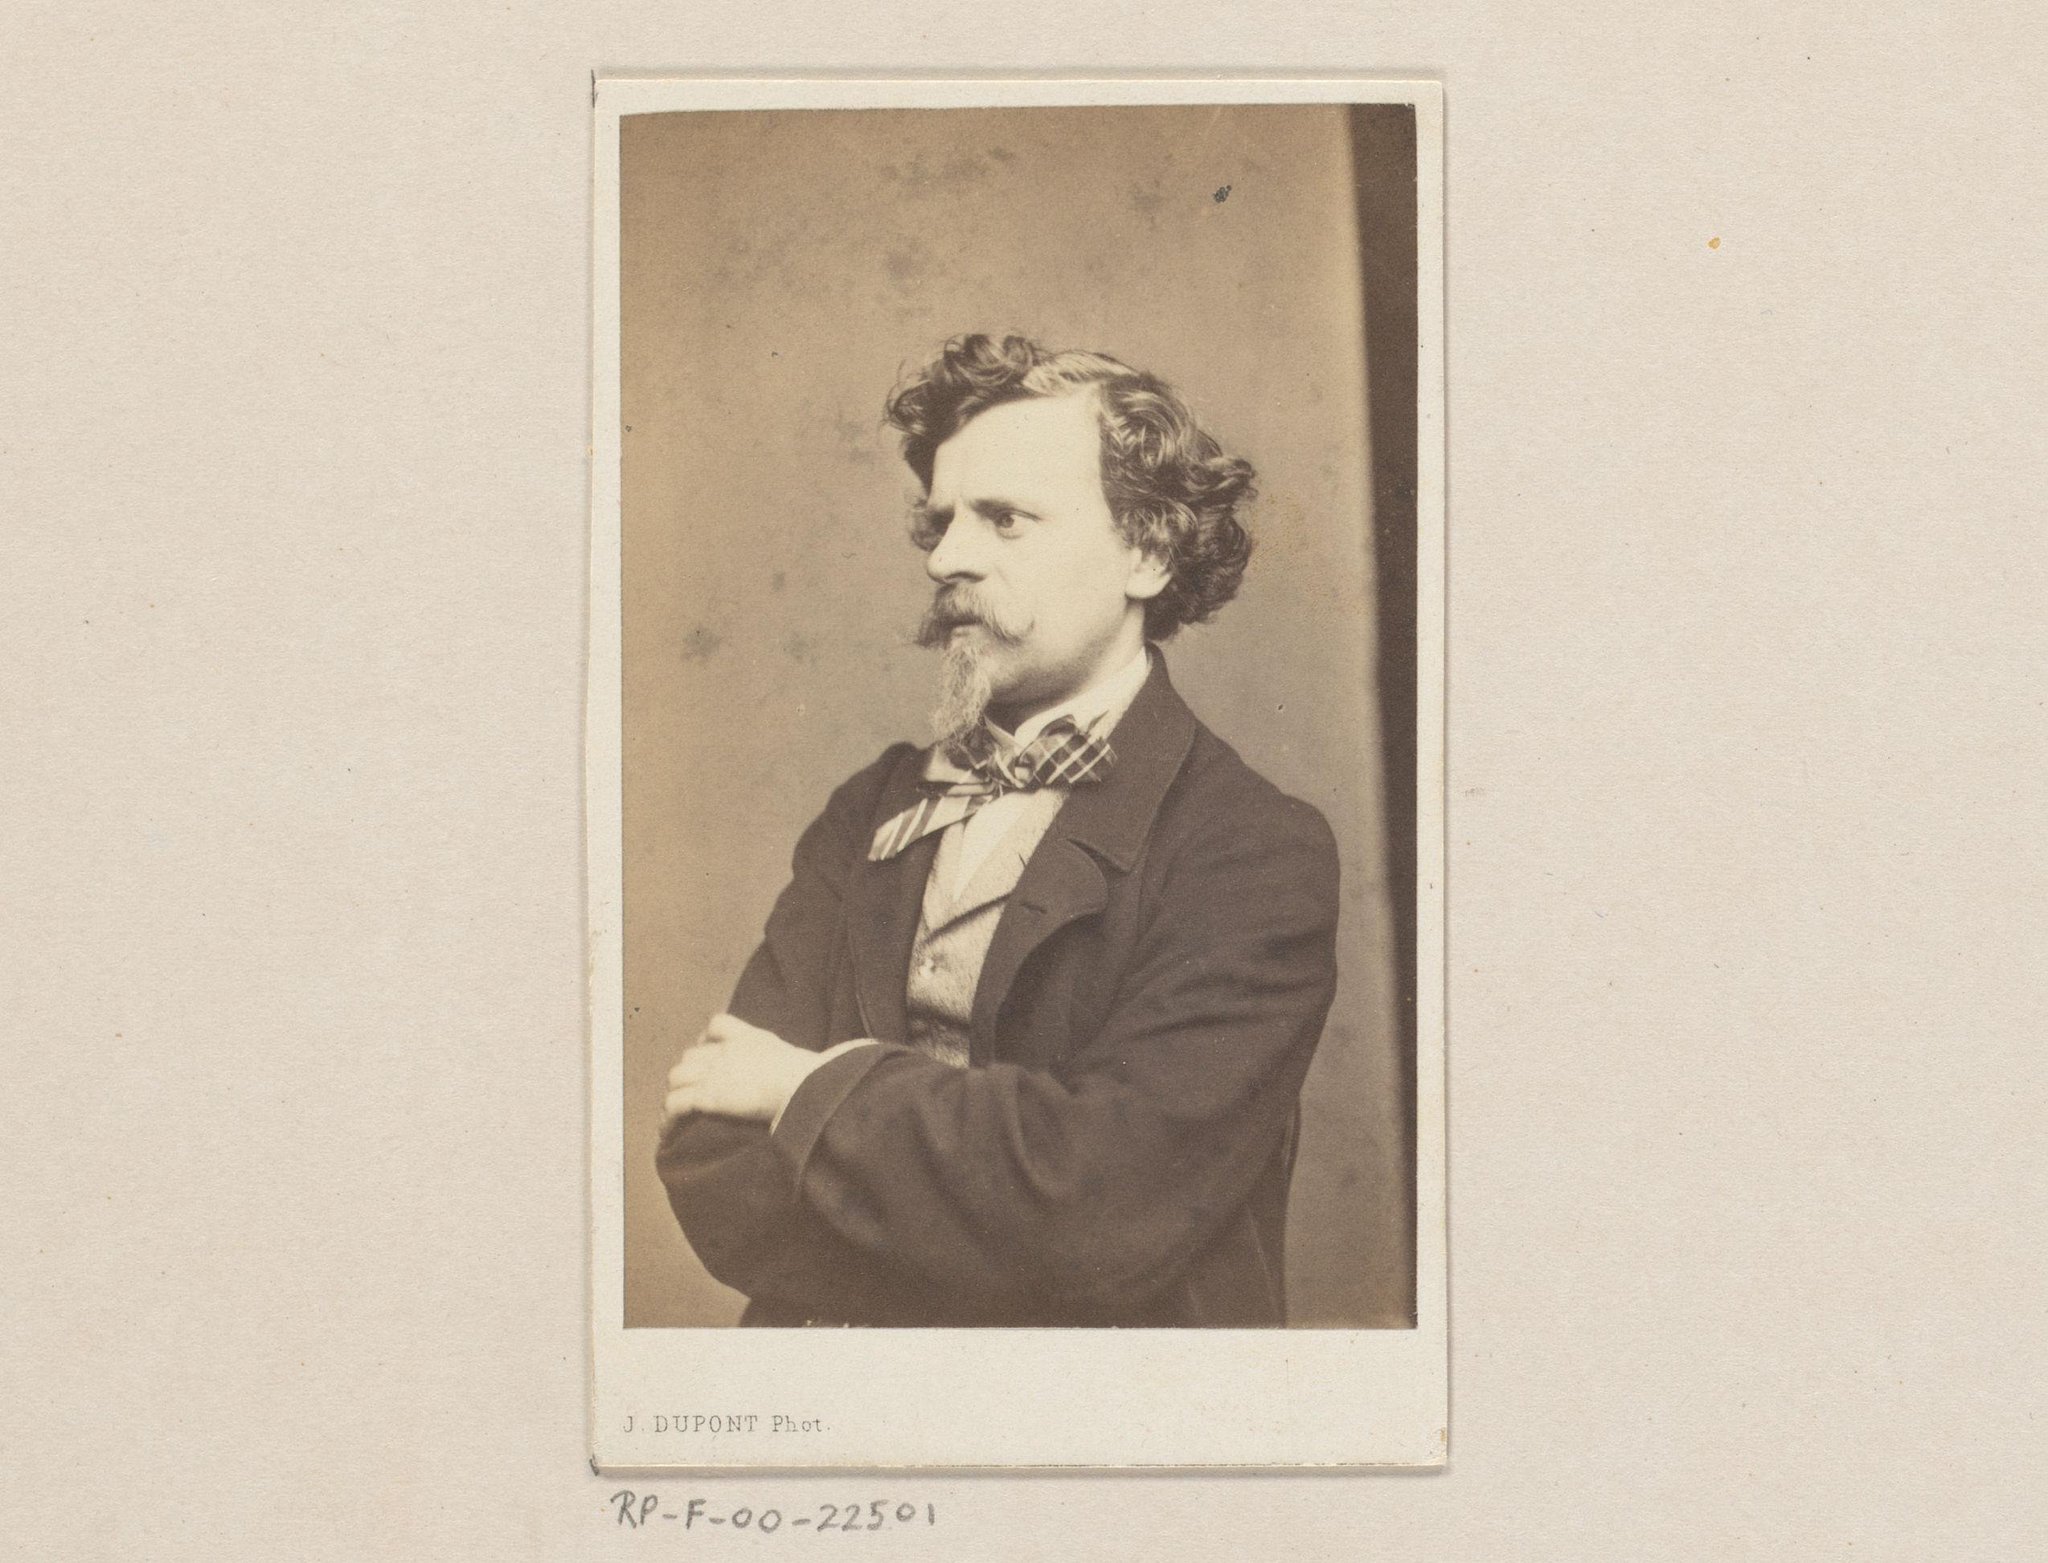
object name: photograph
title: L'École d'Anvers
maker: joseph dupont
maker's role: fotograaf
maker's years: 1818-1901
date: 1861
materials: cardboard, paper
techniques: albumen print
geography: antwerp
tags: ghent, draughtsman, charles venneman, historical persons, portrait, self-portrait of painter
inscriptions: inscription: ‘Venneman’, inscription: ‘Etablissement Photographique/ de/ J. Dupont/ Place de Meir, 32,/ Anvers/ Maison fondée en 1853.’